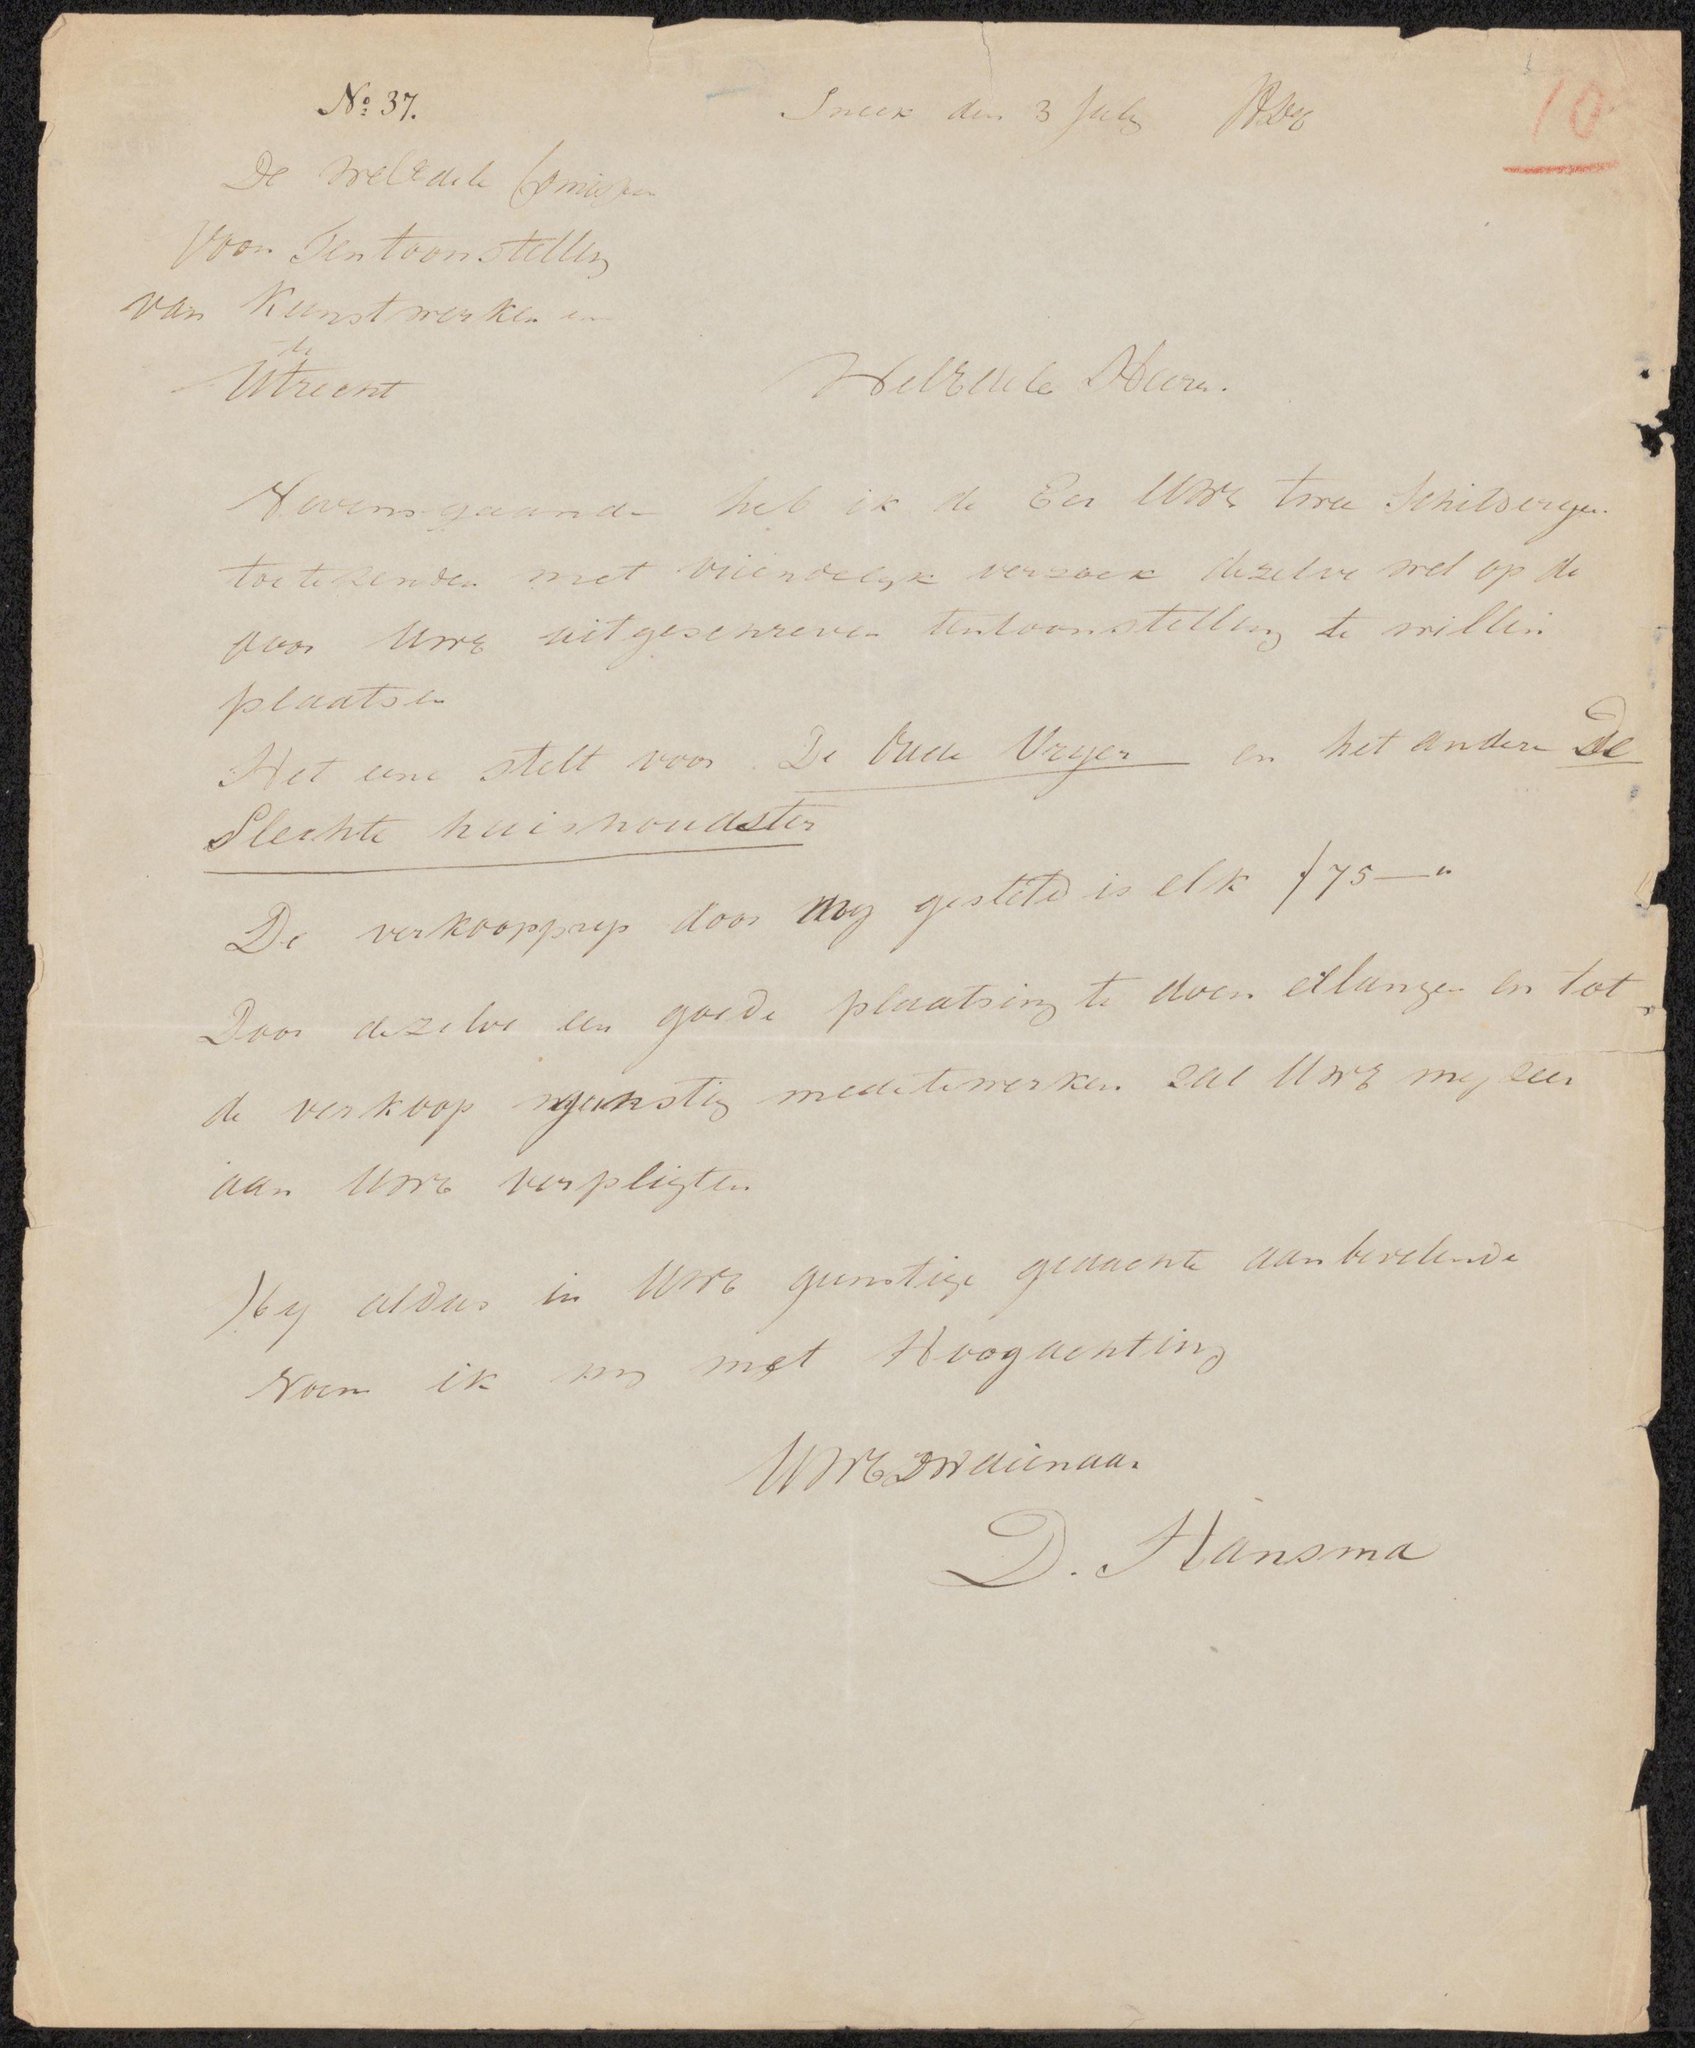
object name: letter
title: Brief aan de commissie van de Tentoonstelling van Levende Meesters in Utrecht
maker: douwe hansma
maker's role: painter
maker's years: 1812-1891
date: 1848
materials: ink, paper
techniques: pen, writing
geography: sneek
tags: painting (including book-illumination, miniature-painting), exhibition ~ art, money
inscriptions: collector's mark: Lugt 2233